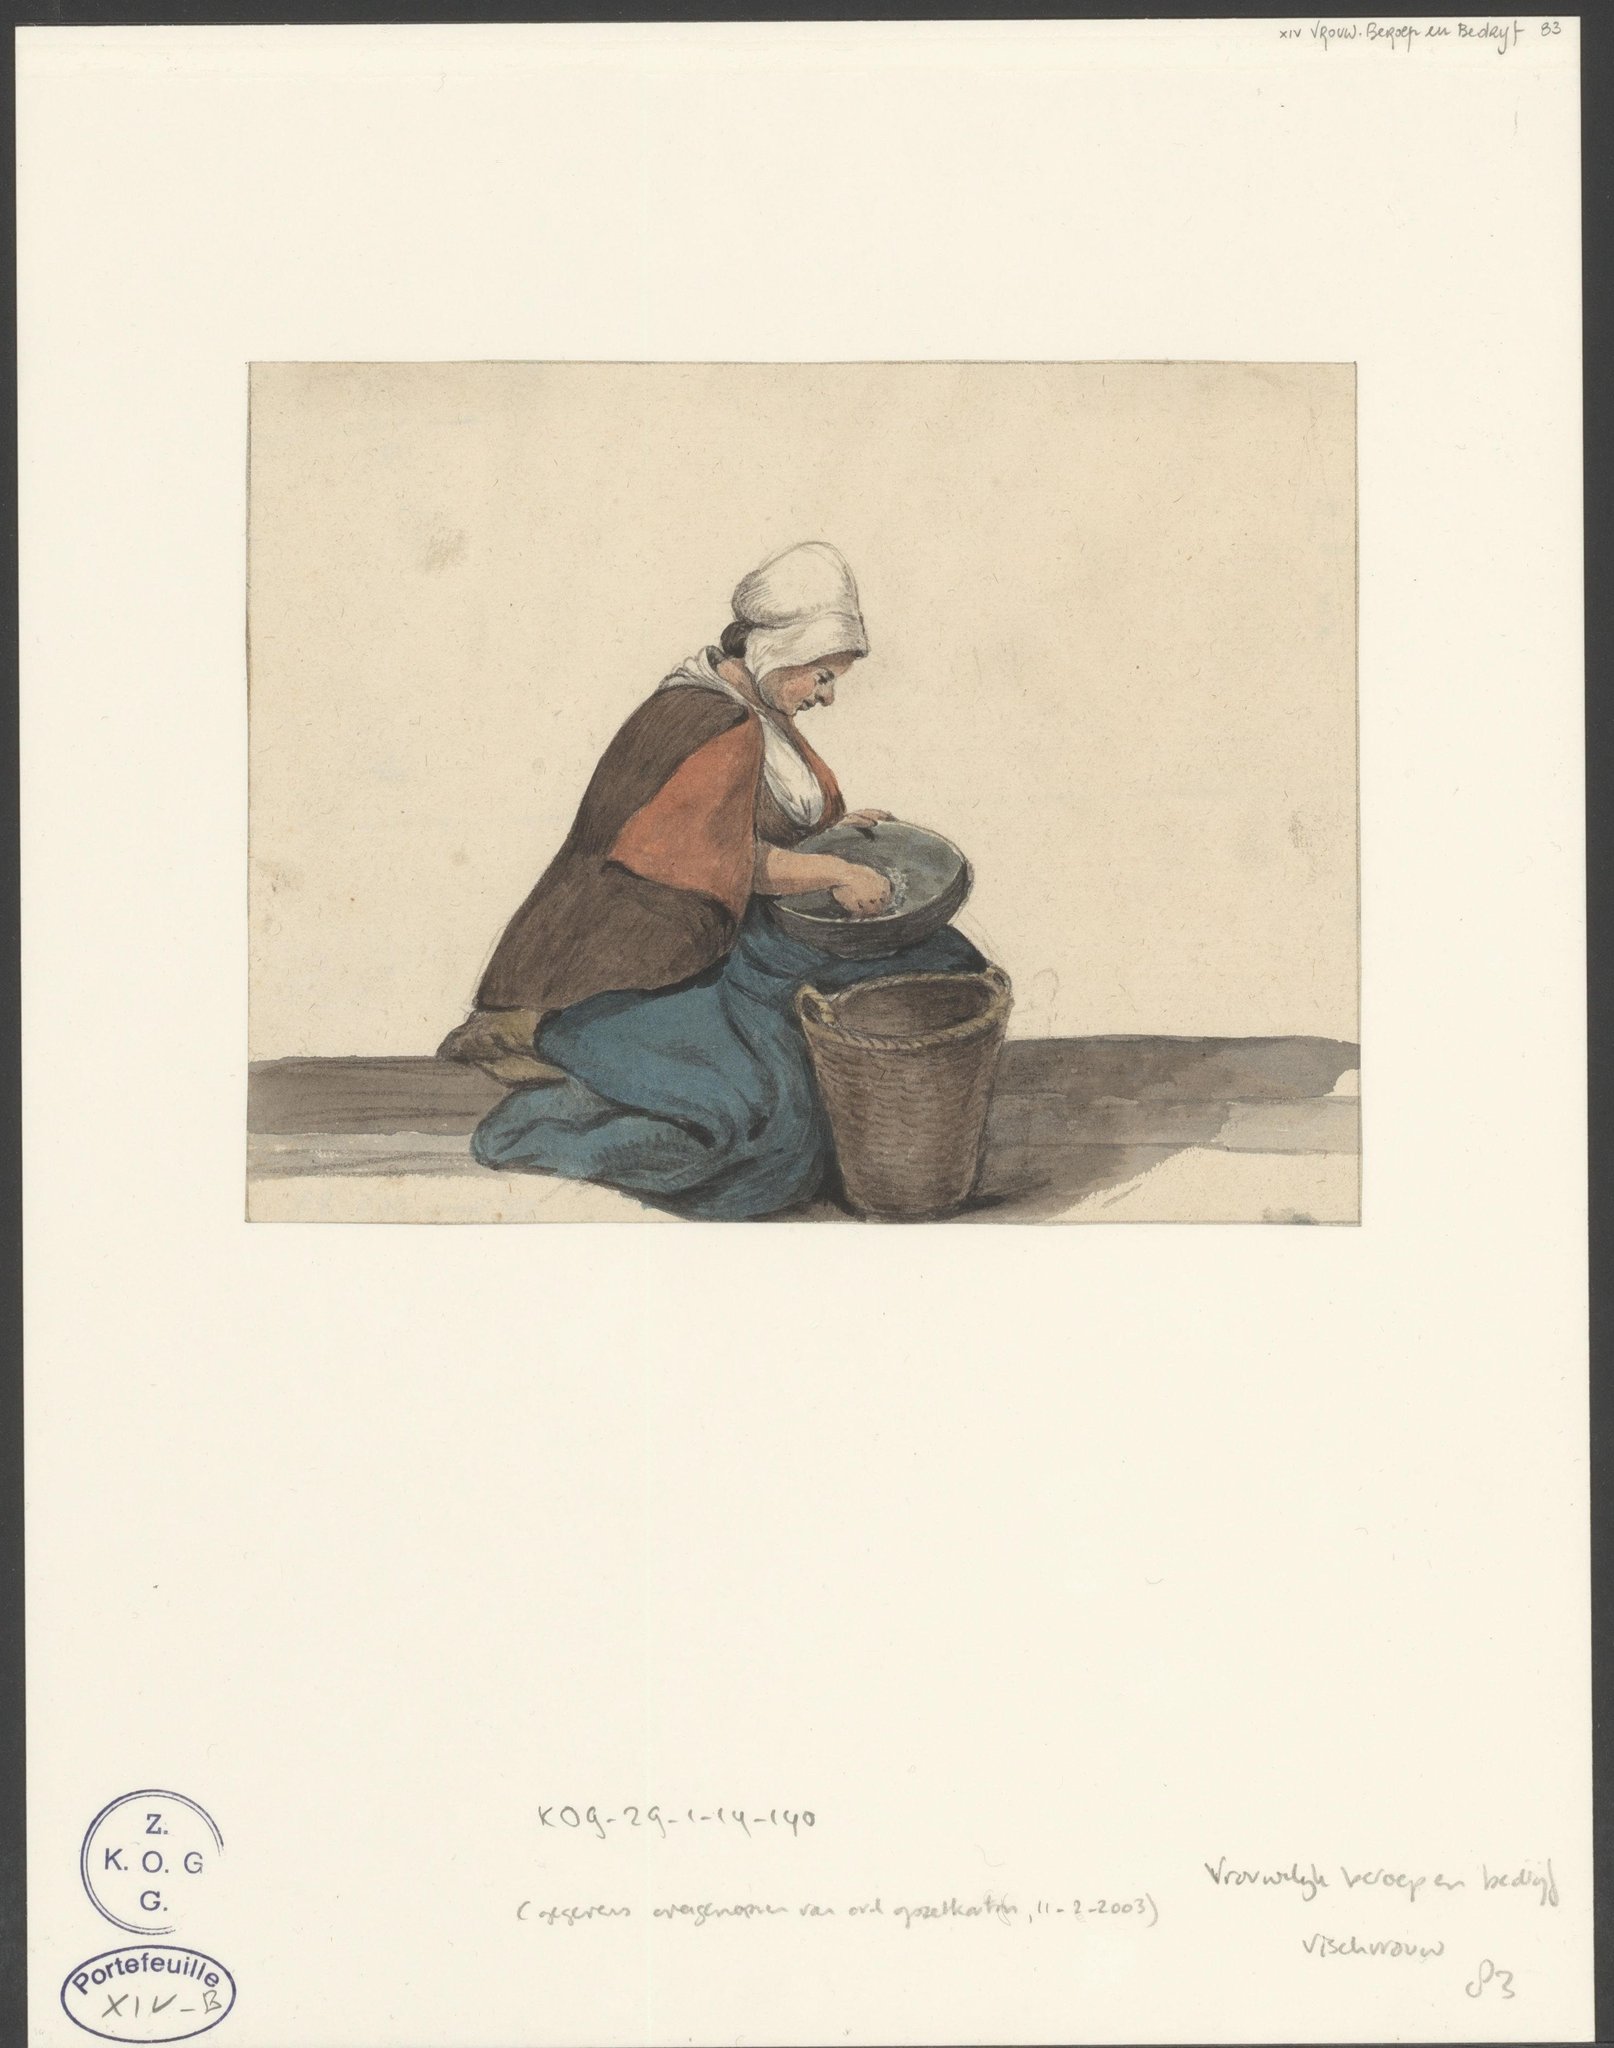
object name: drawing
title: Scheveningse visvrouw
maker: Anonymous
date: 1800-1830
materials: chalk, paper, watercolor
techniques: brush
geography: netherlands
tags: cleaning of material, merchant, salesman (fish), merchant, salesman - bb - women engaged in trade and commerce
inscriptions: collector's mark, collector's mark: Lugt 1641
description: Scheveningse visvrouw. Een vrouw zit geknield bij een mand op haar knieën een schaal schoon te wrijven. Onderwerpsrubrieken binnen de Atlas Zeden en Gewoonten: Beroep en bedrijf. Vrouwelijk beroep en bedrijf. Eet- en drinkwaren.